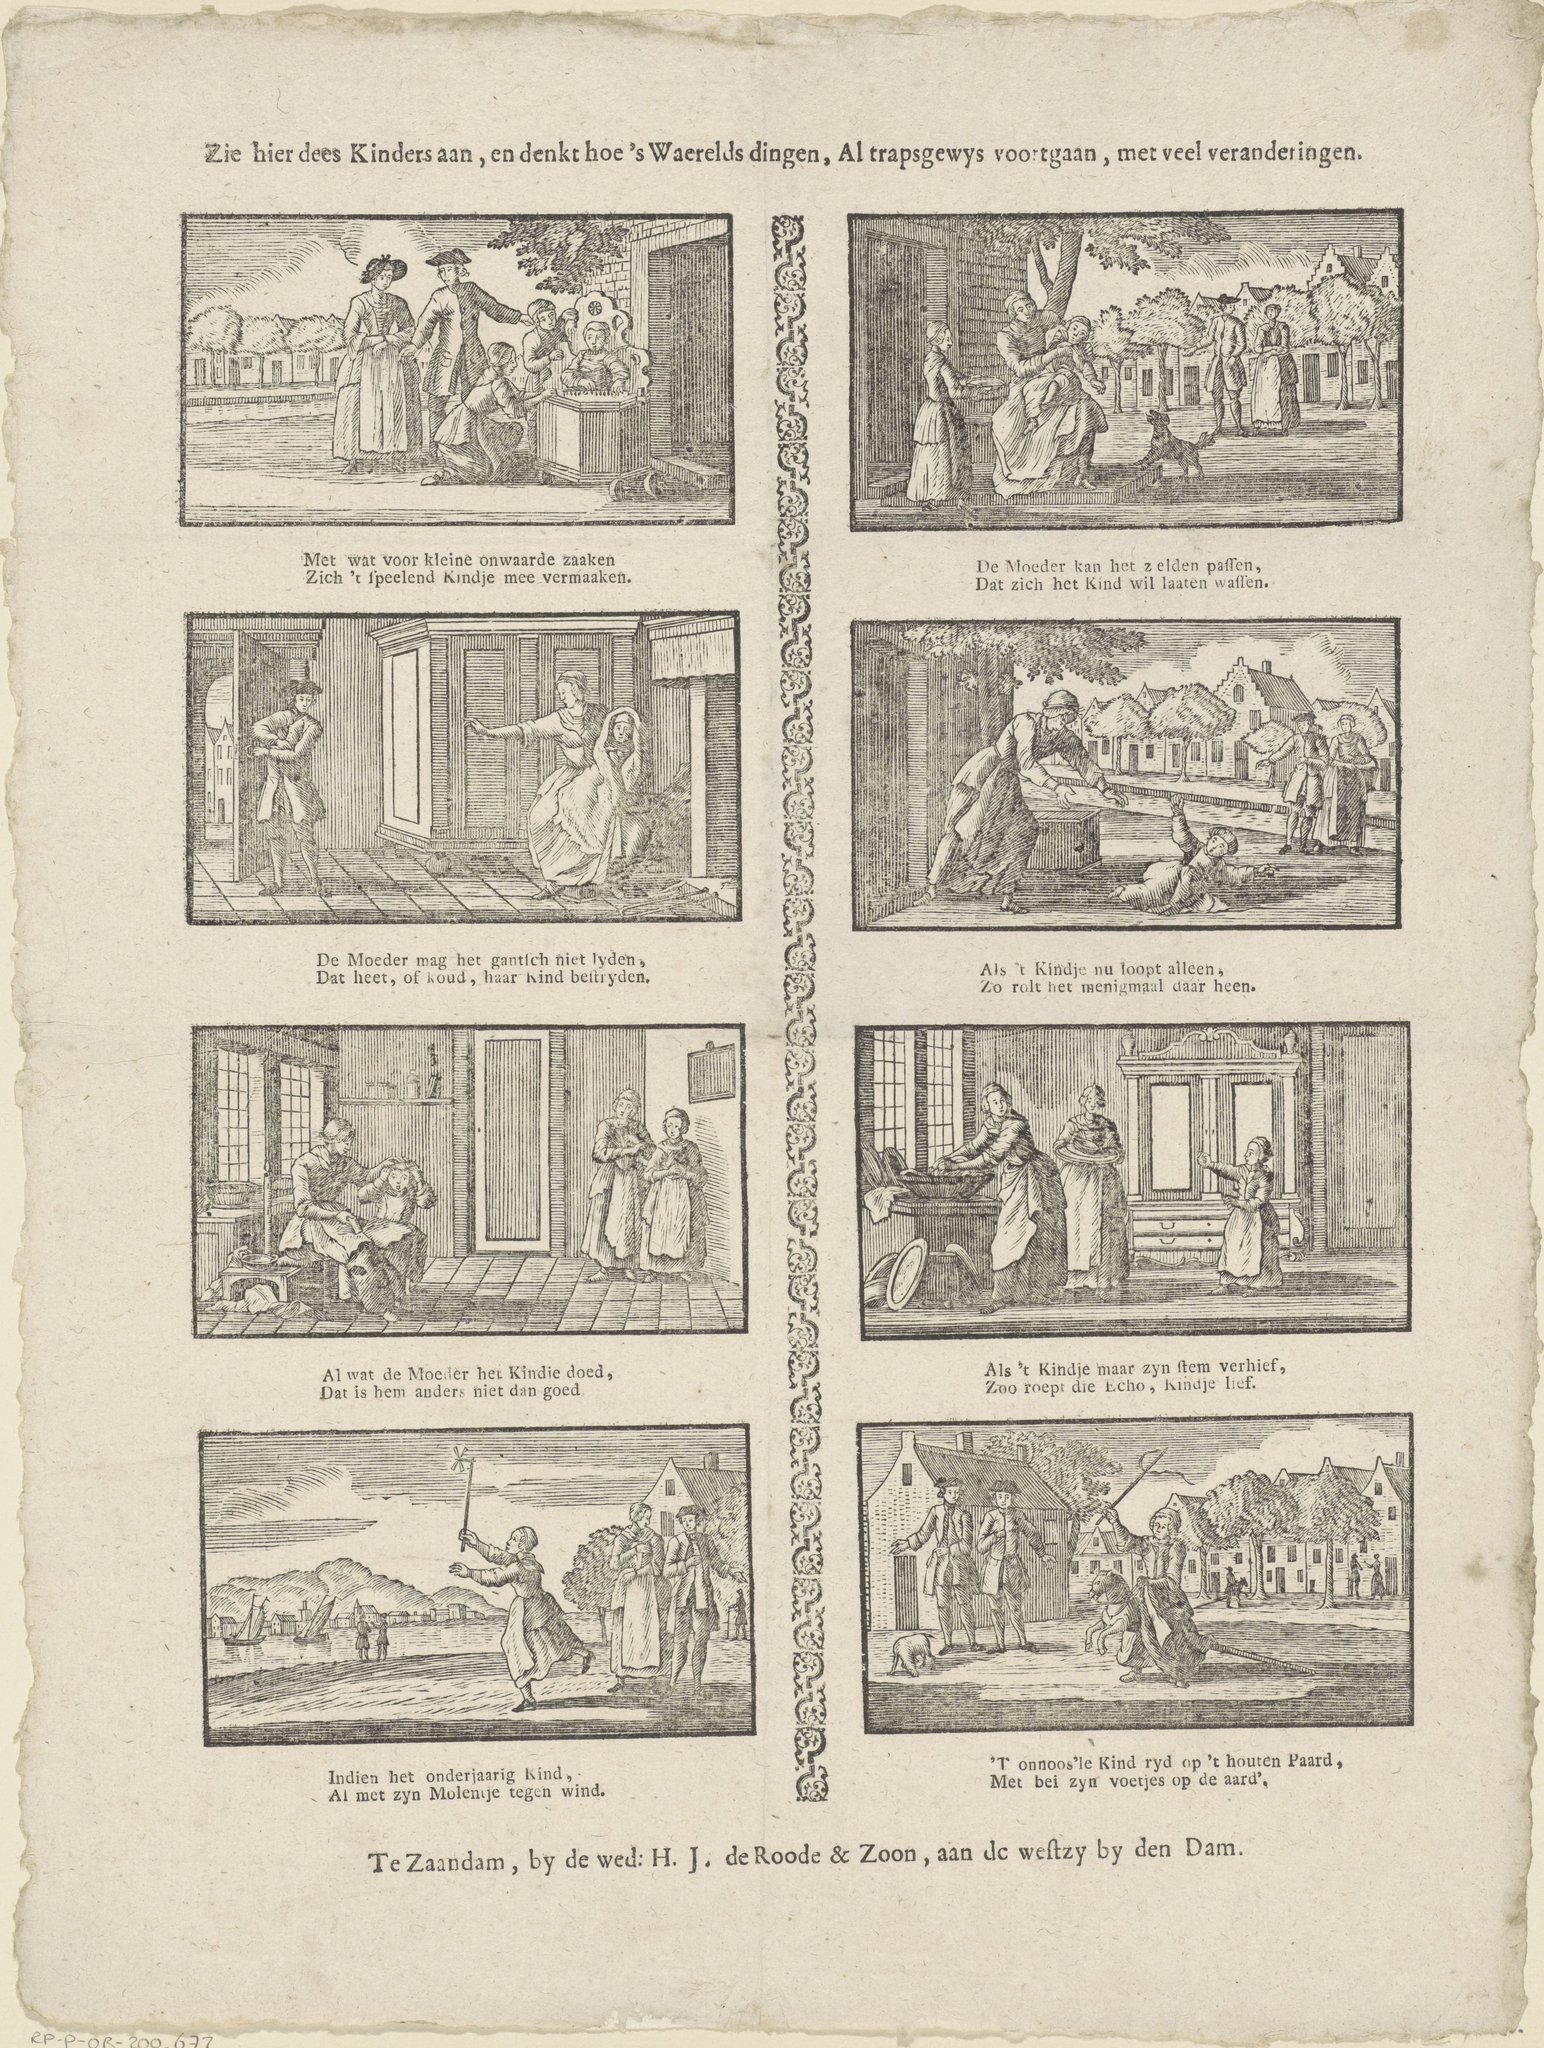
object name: popular print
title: Zie hier dees kinders aan, en denkt hoe 's Waerelds dingen, Al trapsgewys voortgaan, met veel veranderingen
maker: Anonymous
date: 1792-1803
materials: paper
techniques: letterpress printing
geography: zaandam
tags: children's games and plays, child, parental love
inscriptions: collector's mark: Lugt 2760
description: Blad met 8 voorstellingen van bezigheden en spelen voor kinderen. Onder elke afbeelding een tweeregelig vers.